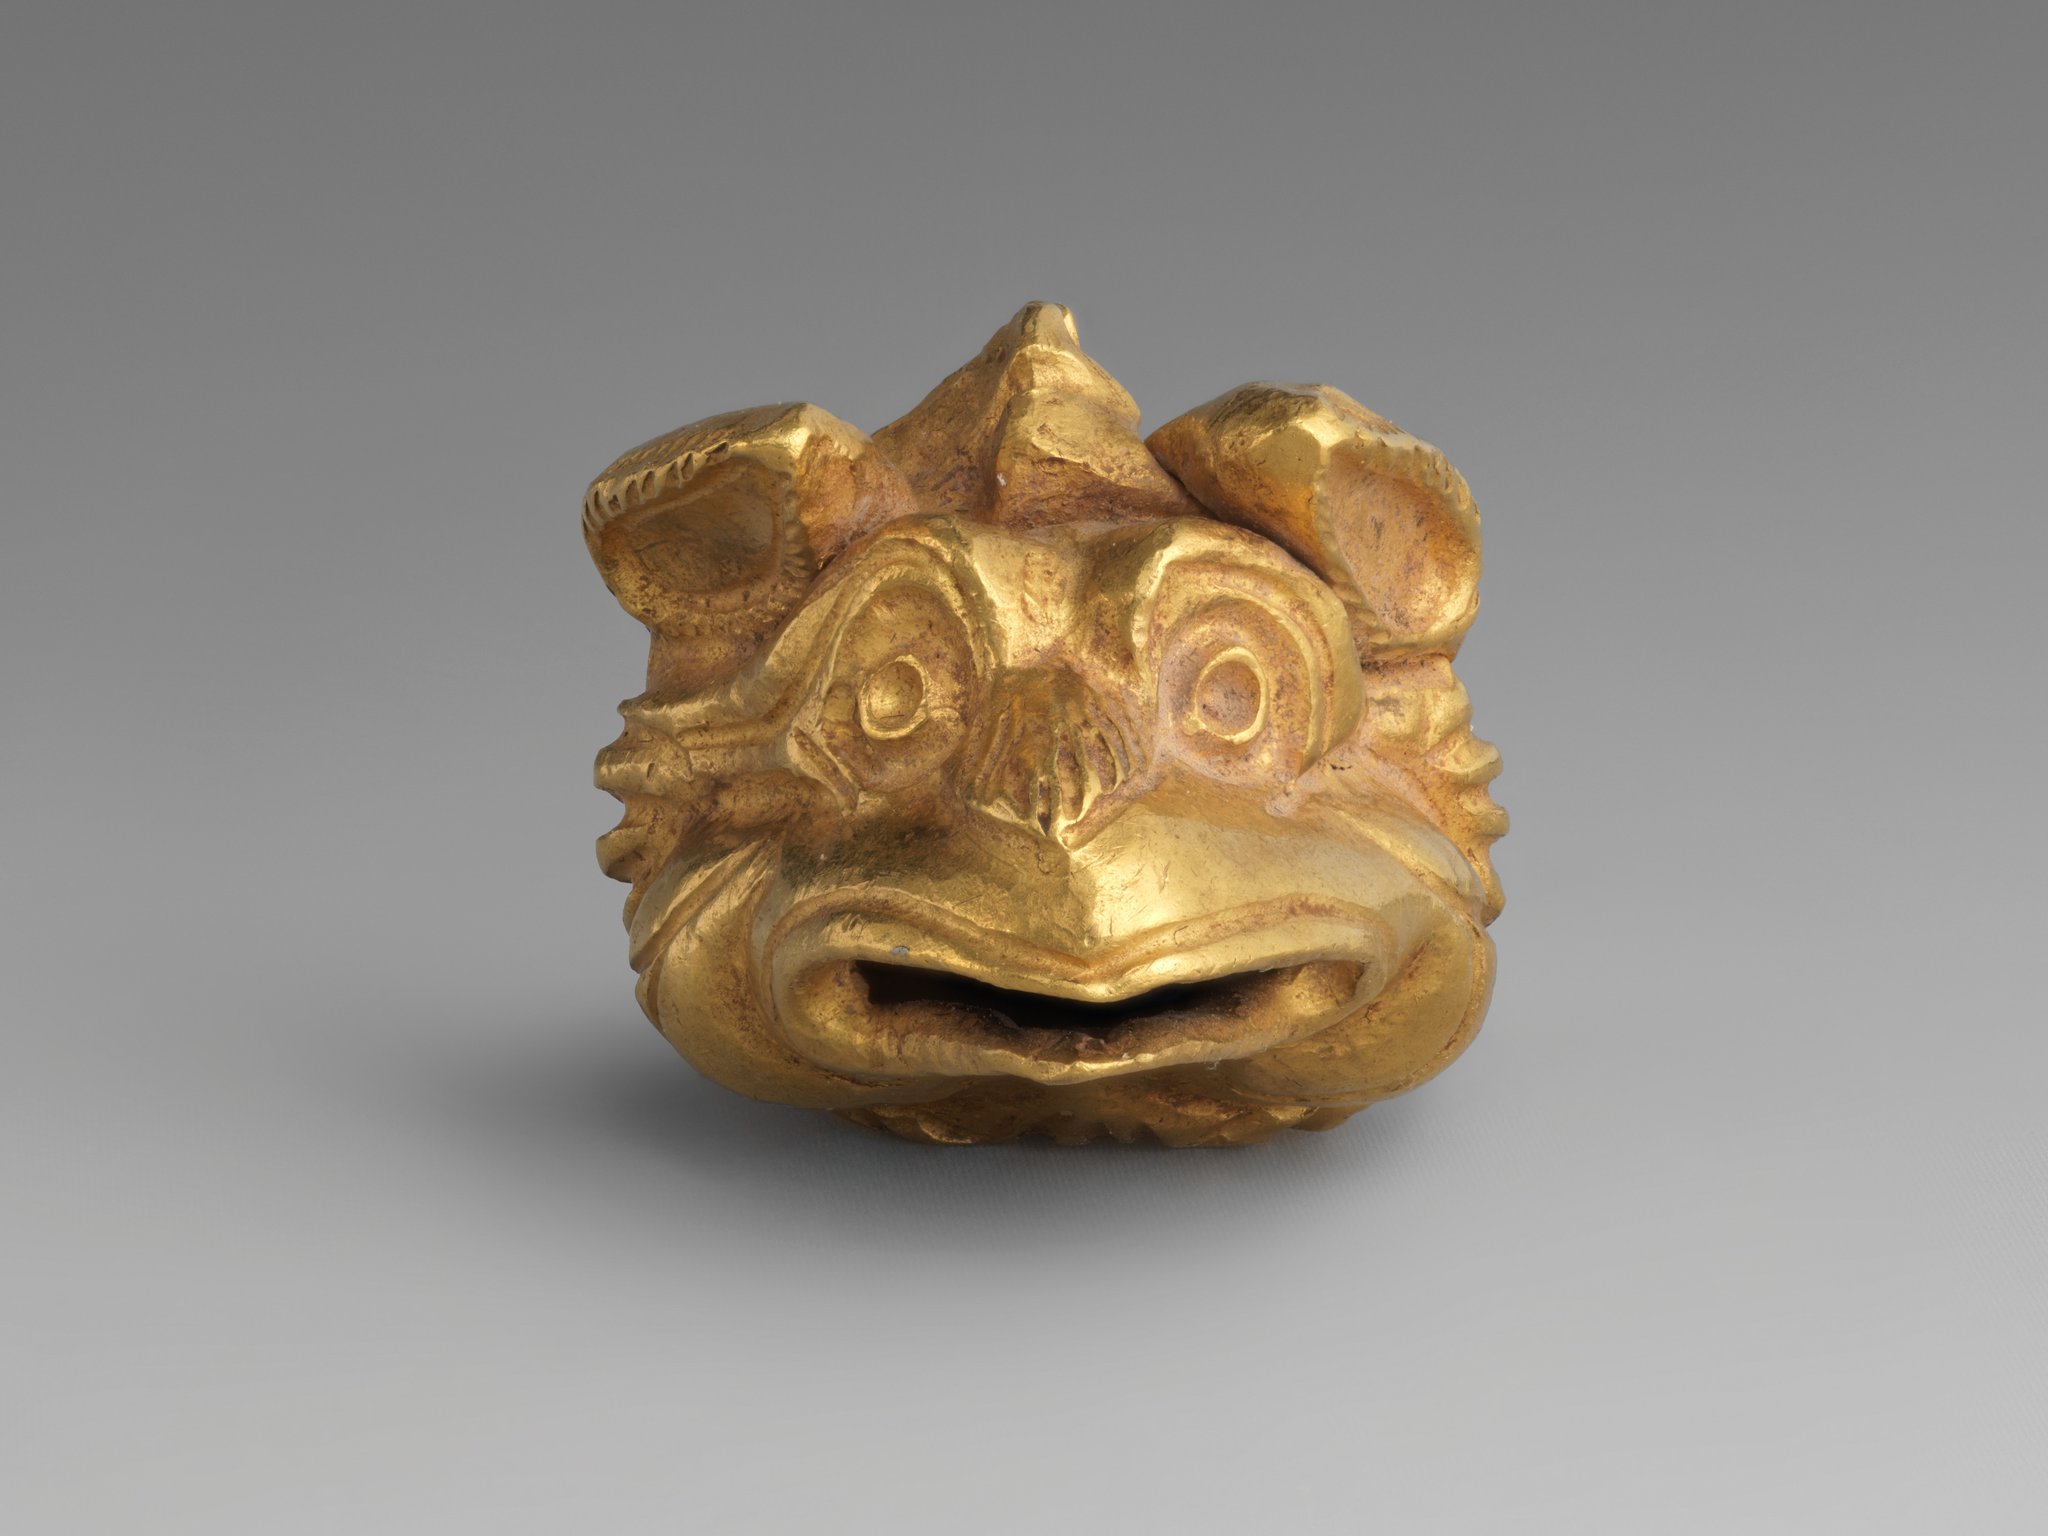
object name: ornament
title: Ornament in the shape of a griffin head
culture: sarmatian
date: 500-401 BCE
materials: gold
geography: eurasian steppes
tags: griffins